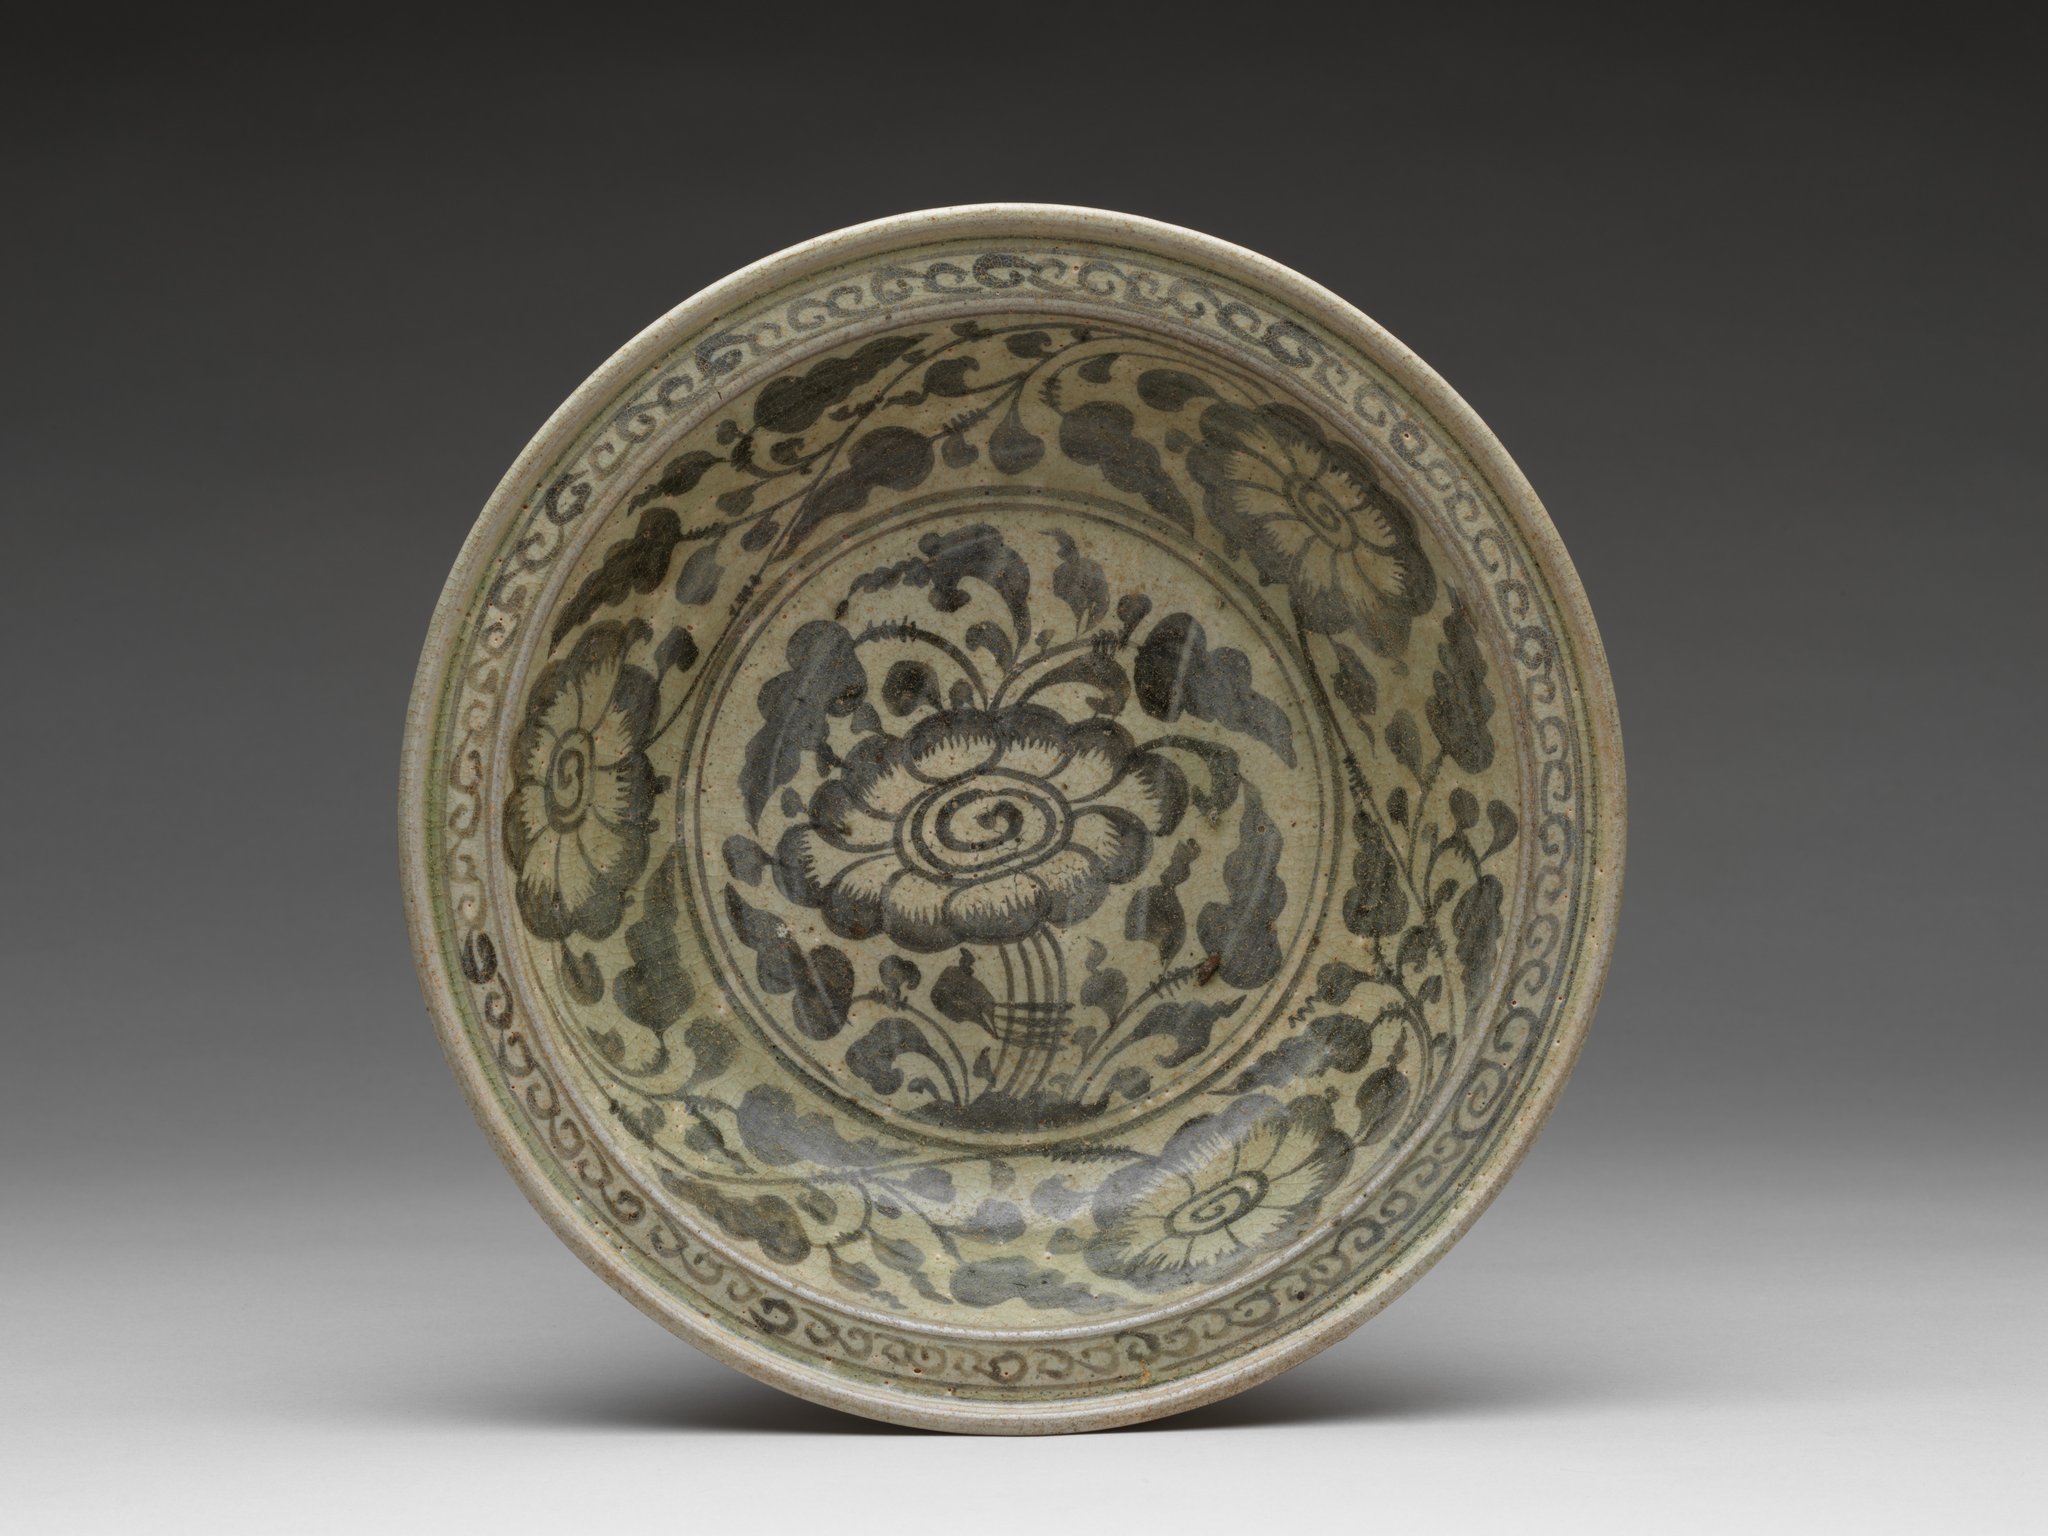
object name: bowl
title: Bowl with peony design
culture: thai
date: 1401-1600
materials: iron, stoneware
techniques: painting, underglaze